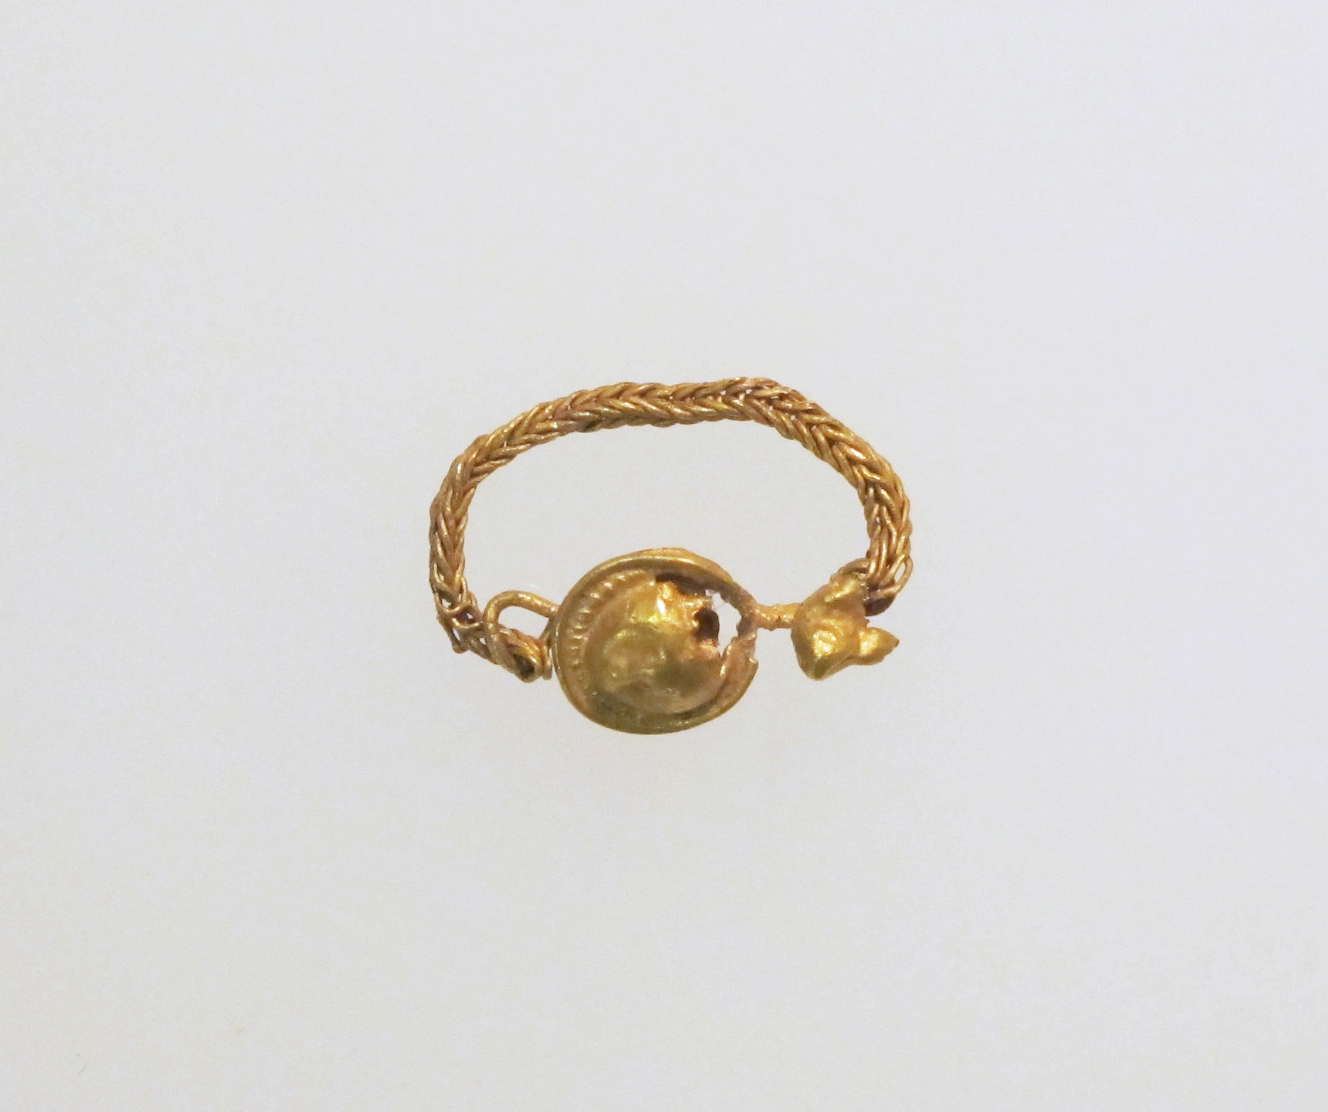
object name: earring with disc, chain and bird's head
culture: roman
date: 1-200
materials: gold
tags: birds